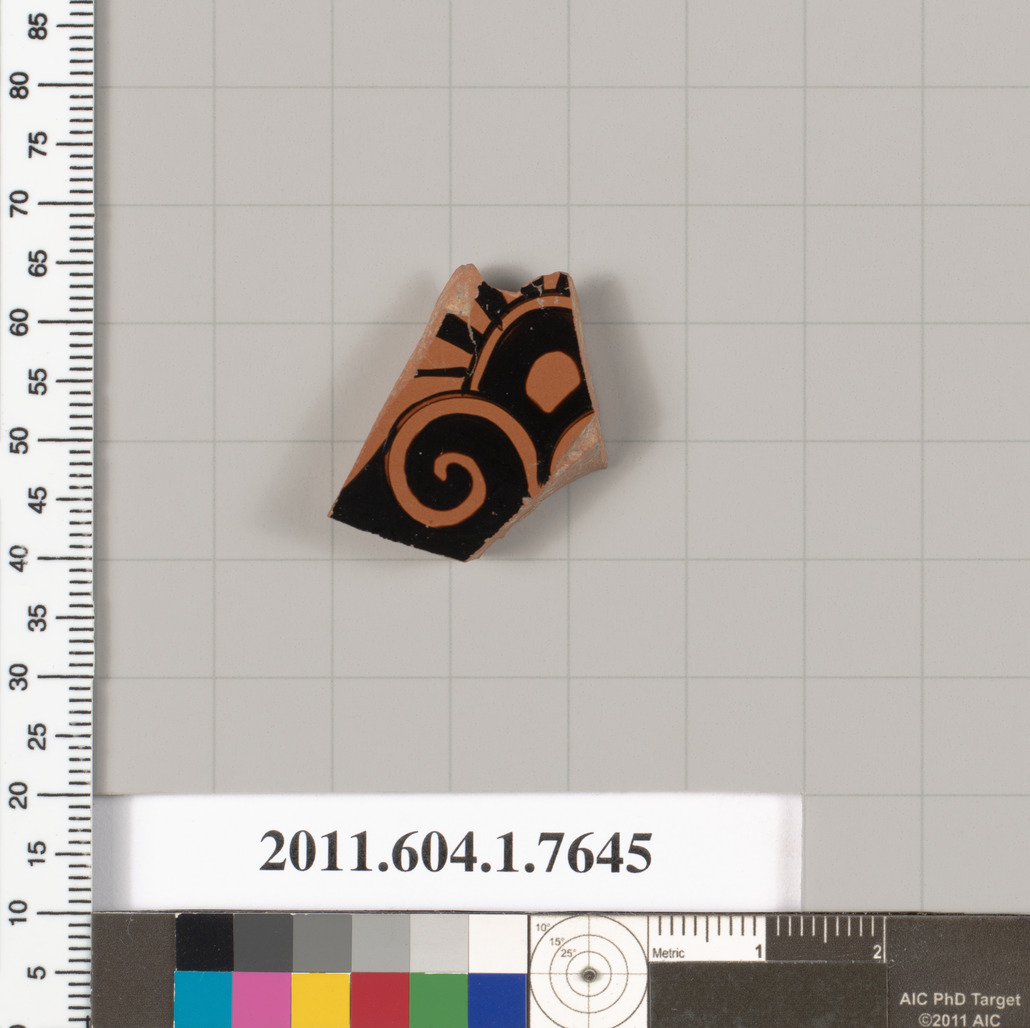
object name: kylix fragment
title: Terracotta fragment of a kylix (drinking cup)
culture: greek, attic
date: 460-450 BCE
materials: terracotta